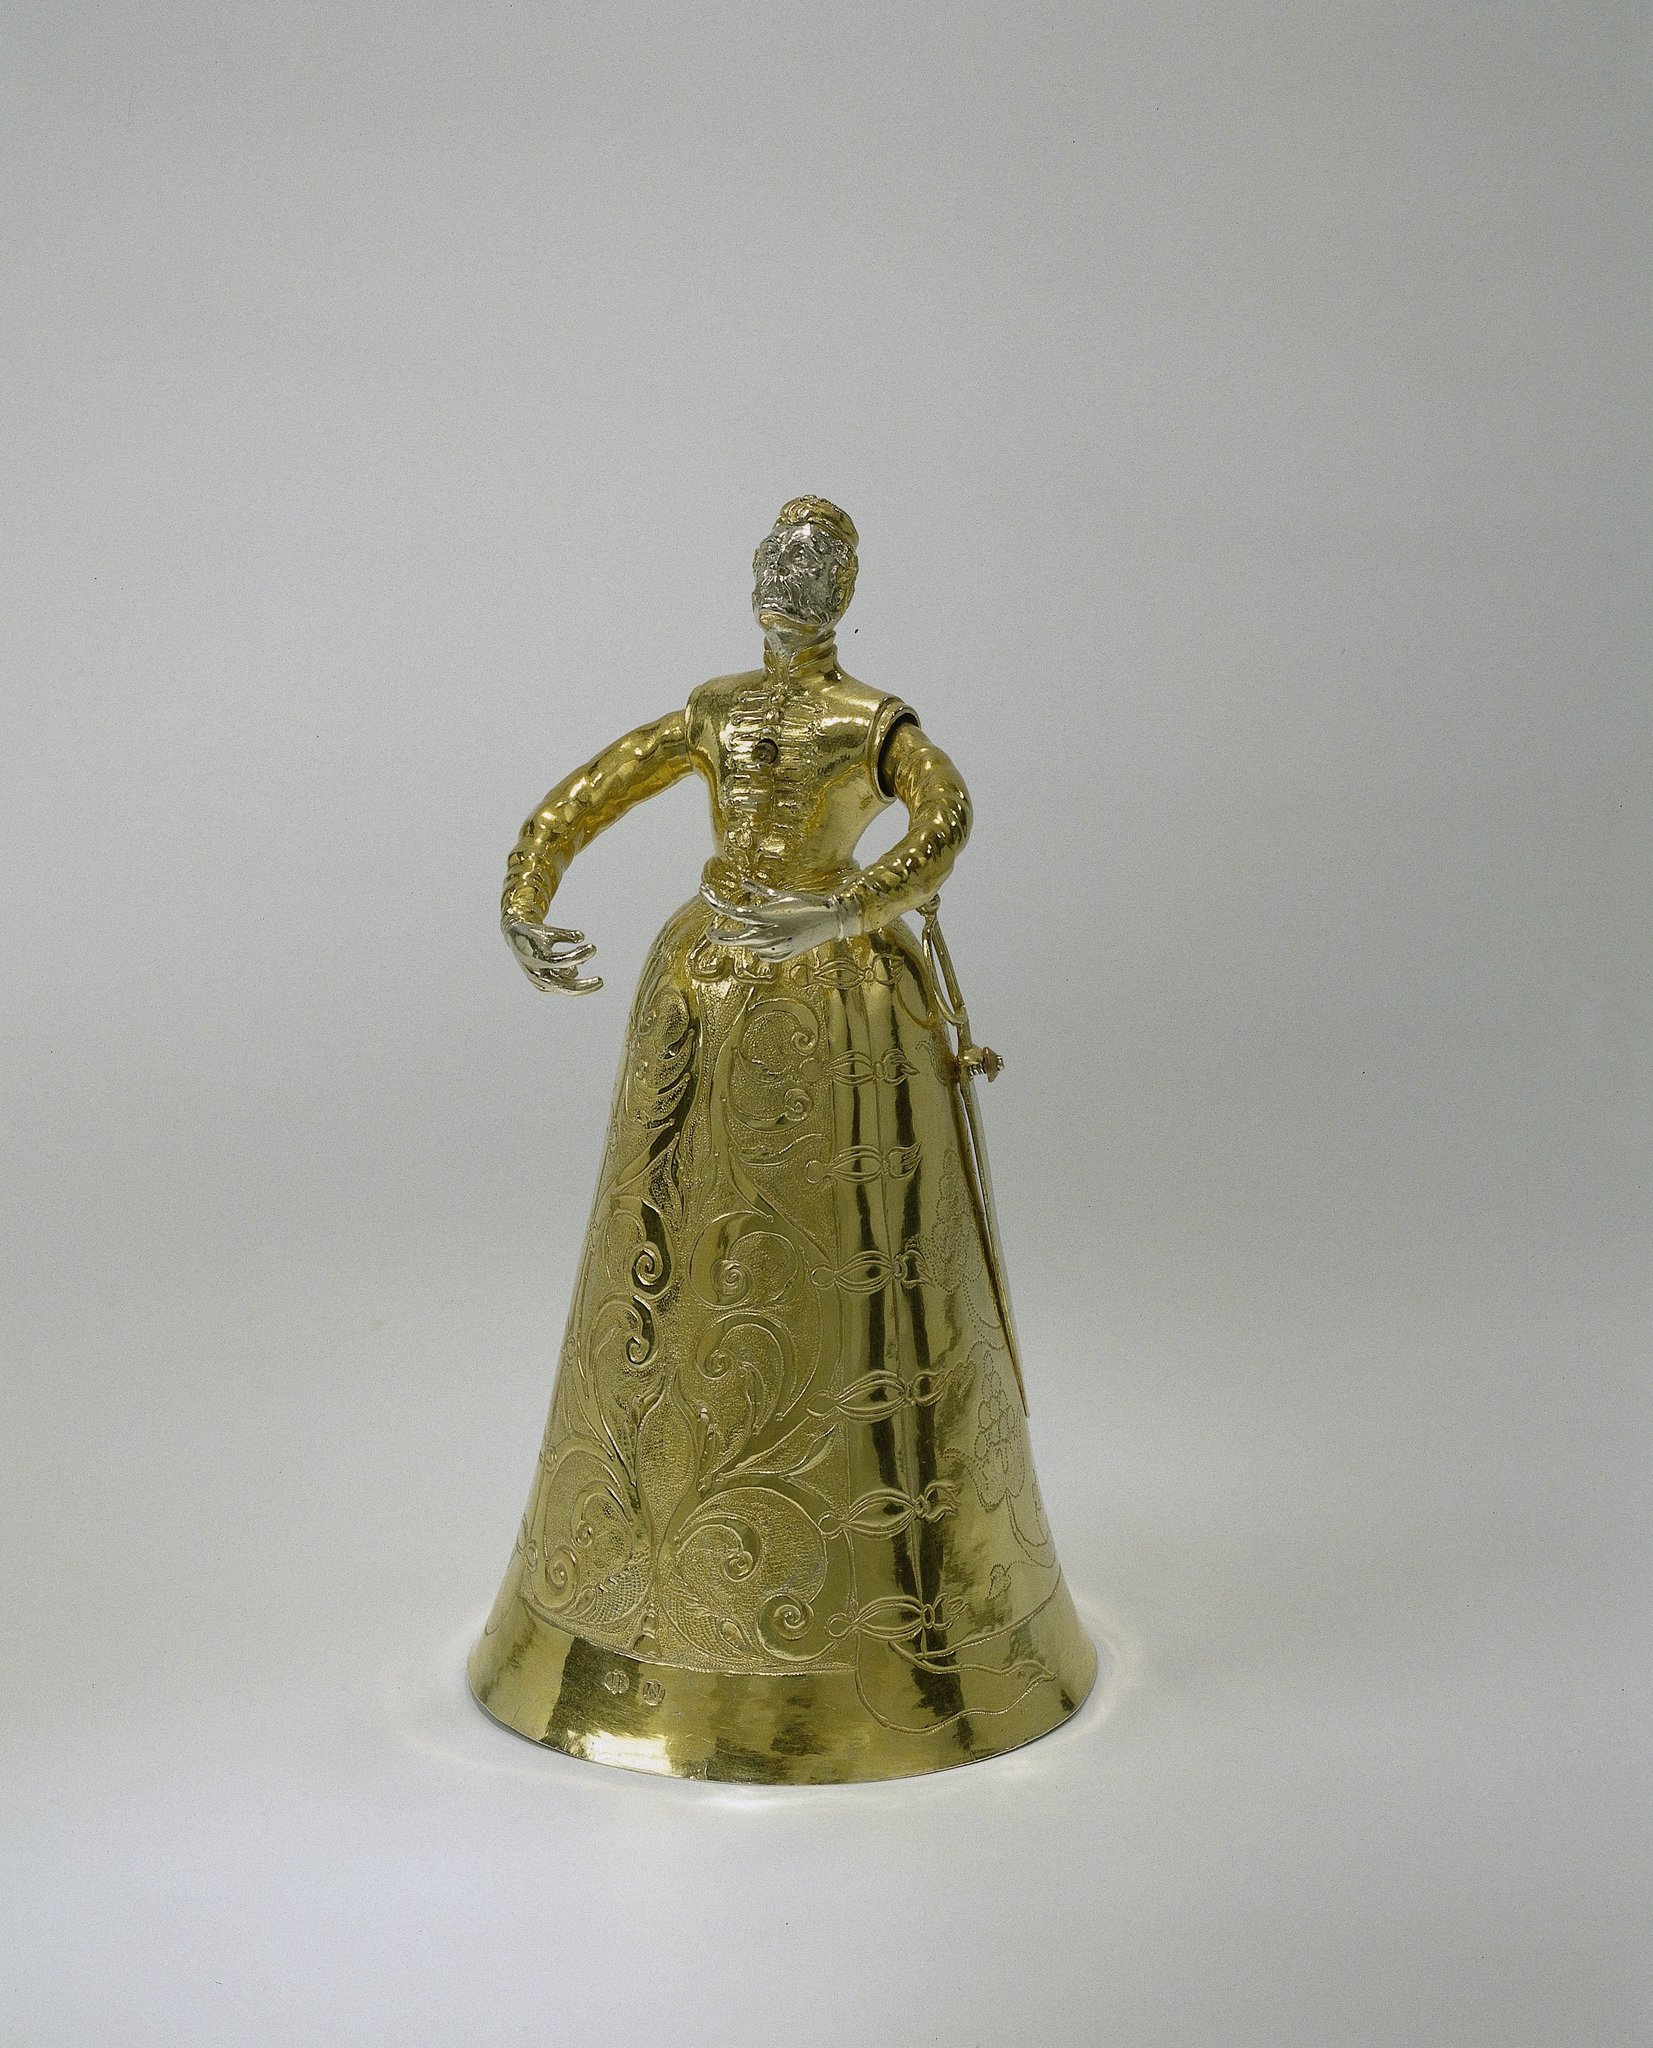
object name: cup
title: Beker, ook wel Frauenbecher genoemd, in de vorm van een mannenfiguur met beweegbare armen. Kelk in de vorm van een uitstaande rok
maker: jörg ruel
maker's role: silversmith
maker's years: -1625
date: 1600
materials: silver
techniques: gilding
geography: nuremberg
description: Frauenbecher. Silver-gilt. Nuremberg, c. 1600, by Georg Rühl.